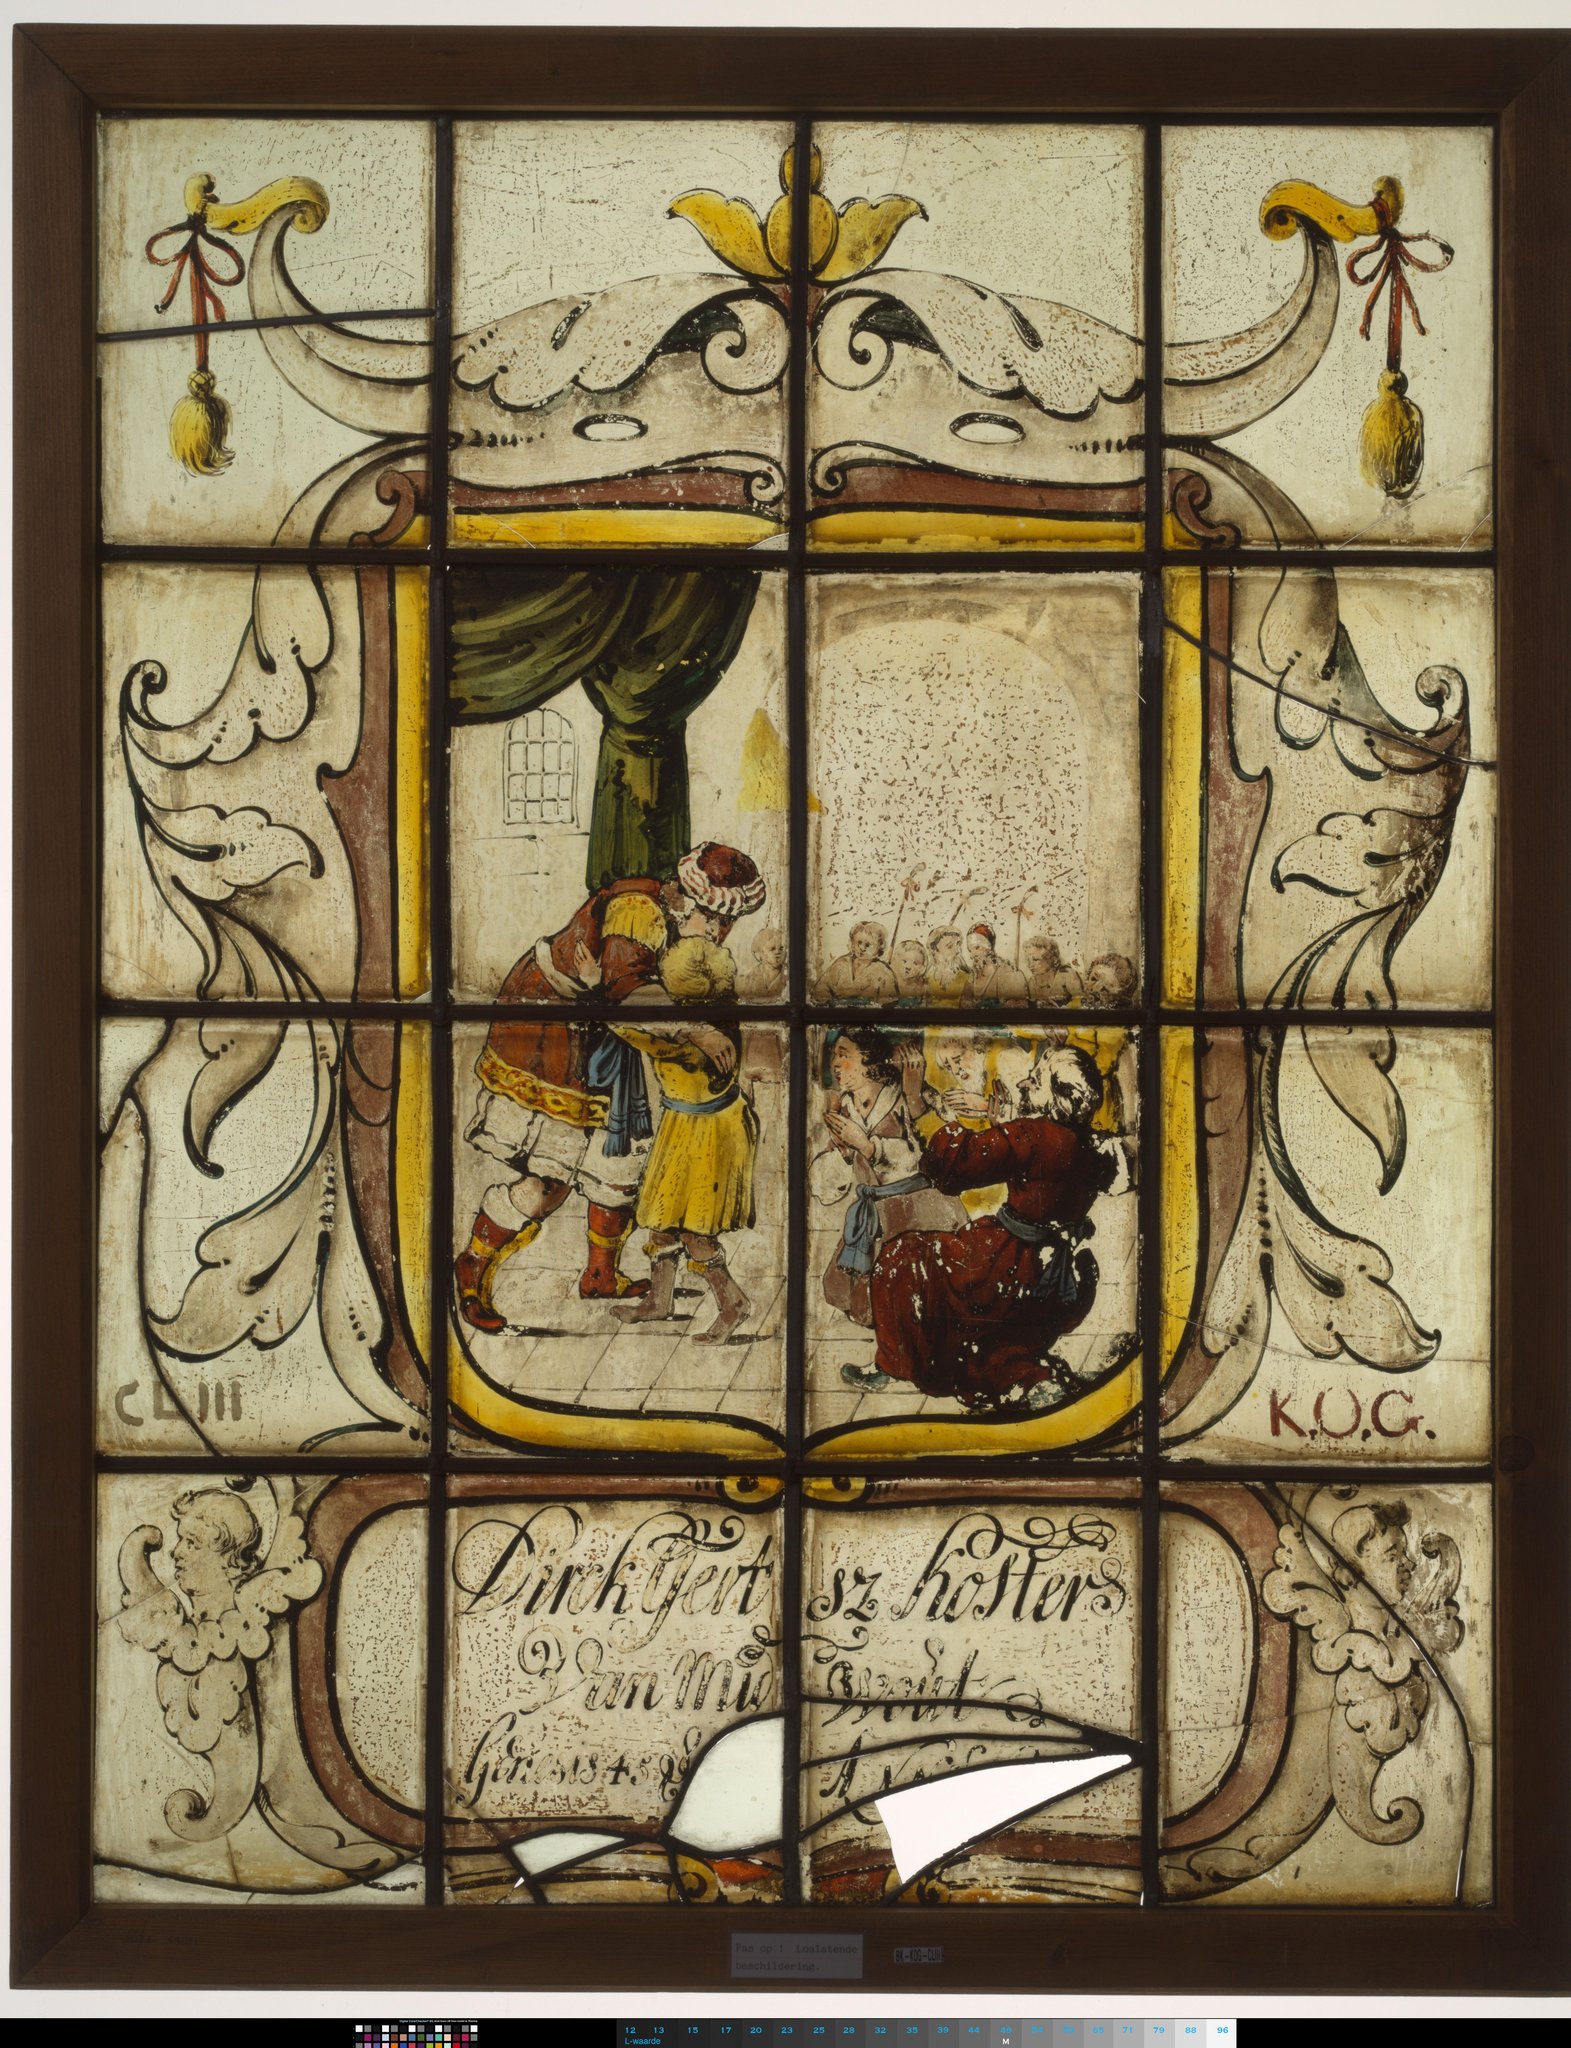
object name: light window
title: Ruit met voorstelling van Jozef en Benjamin met de broeders, met onderschrift in cartouche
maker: Anonymous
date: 1608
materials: glass, lead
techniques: leading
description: Paneel waarin een bijbelse voorstelling: Jozef en Benjamin met de broeders. Met onderschrift in cartouche "Derek Geritz Kosters van Midwout Genesis 45 f Anno 1608".